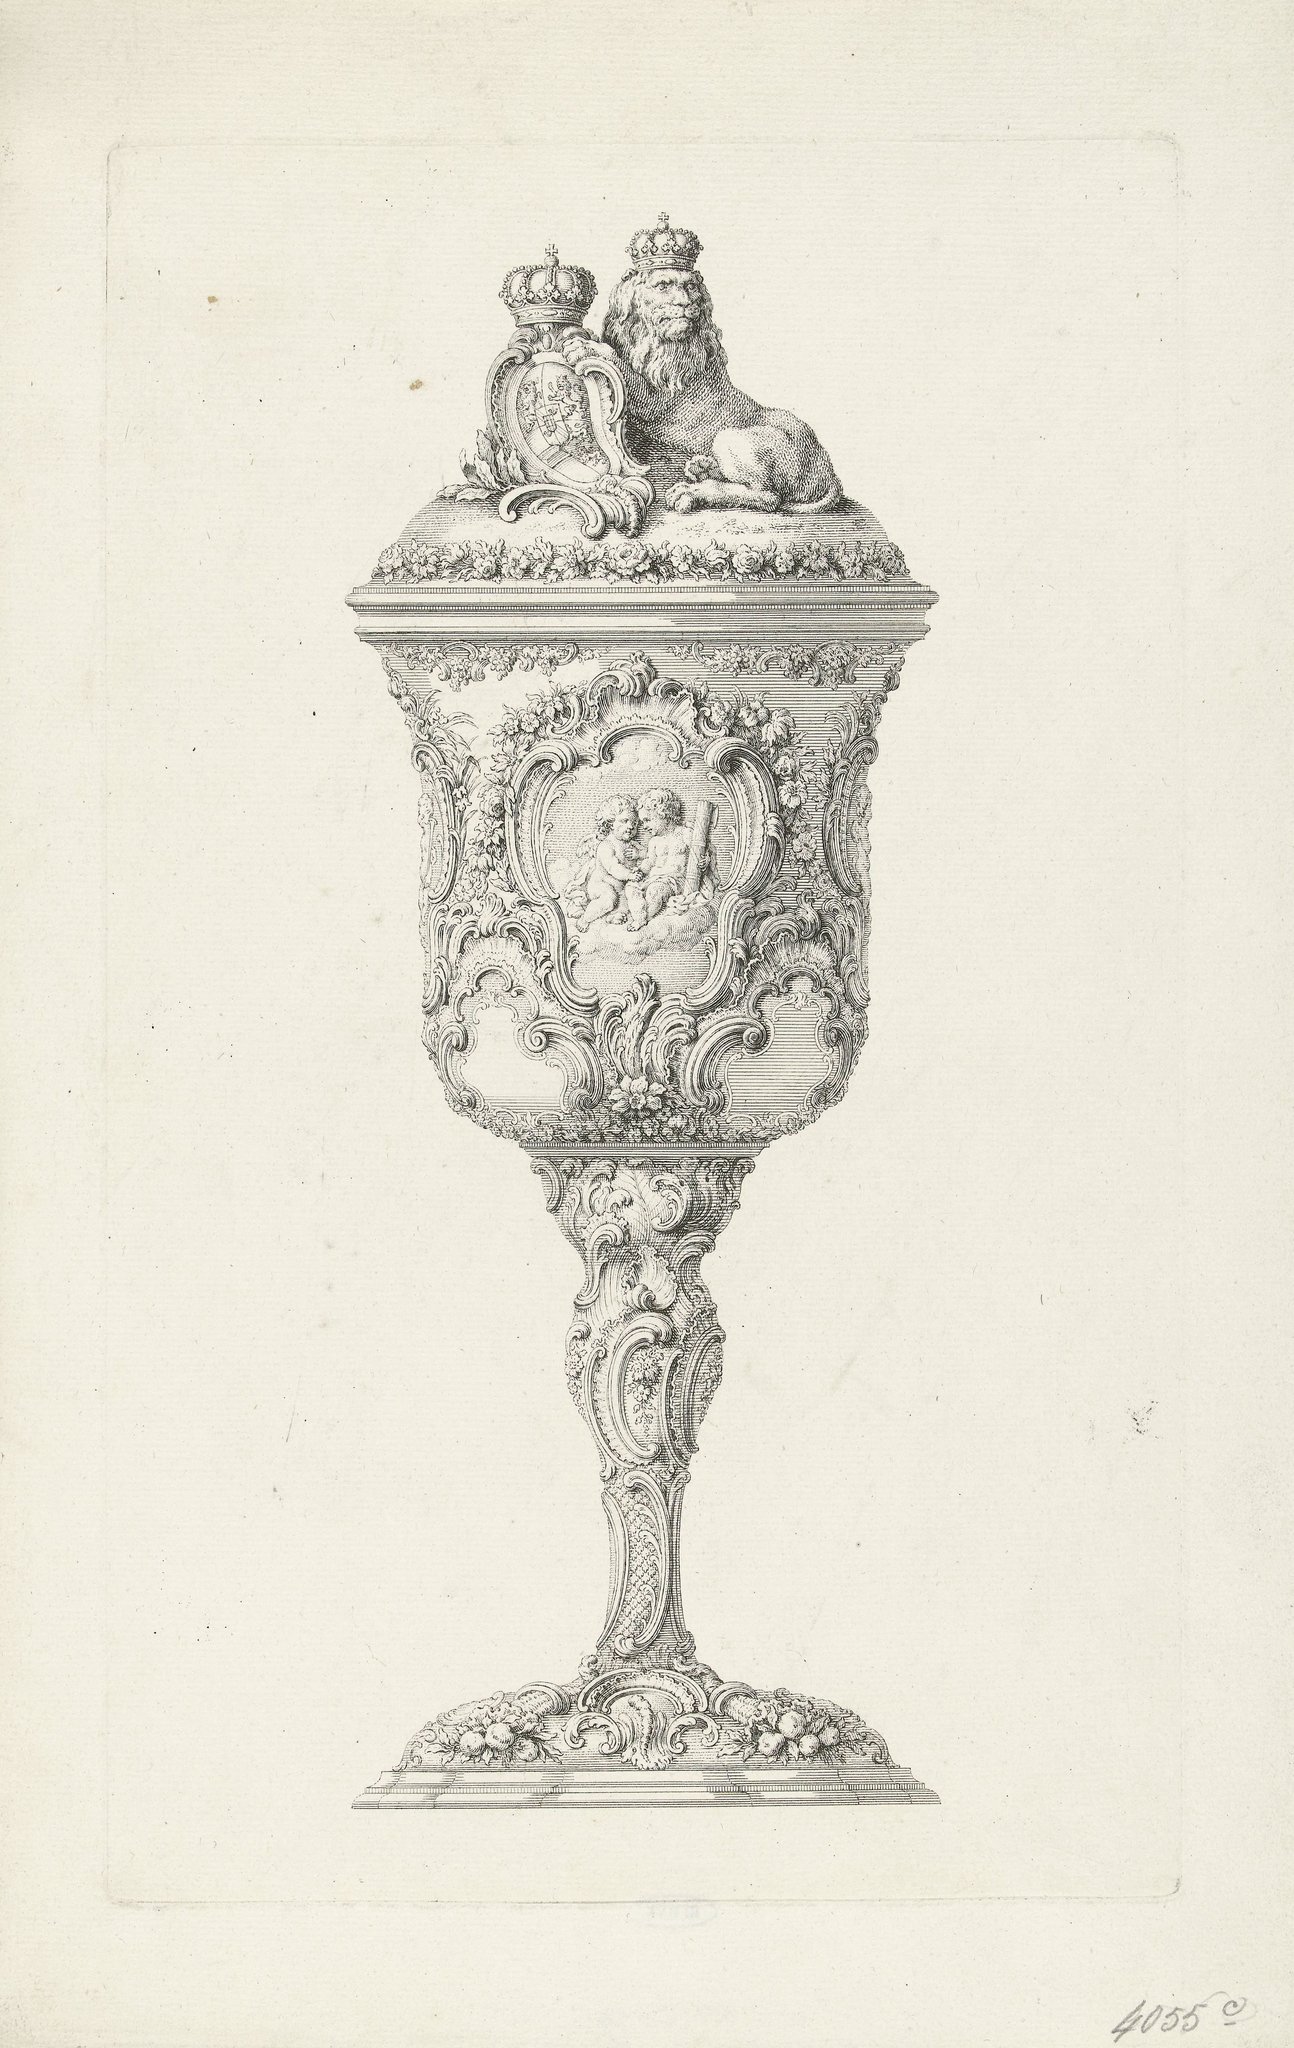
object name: print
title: Gouden beker van de Haagse schutterij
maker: jacob van der schley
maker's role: draughtsman, print maker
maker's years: 1715-1779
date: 1753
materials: paper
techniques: etching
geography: northern netherlands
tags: willem iv (prins van oranje-nassau), the hague, anna van hannover, cup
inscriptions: collector's mark: Lugt 2228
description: Een gouden beker door stadhouder Willem IV toegezegd aan de Haagse schutterij en na zijn dood gepresenteerd door prinses Anna op 8 mei 1753. Op deze voorstelling de beker als geheel. De beker vervaardigd door Philippe Métayer te Amsterdam.